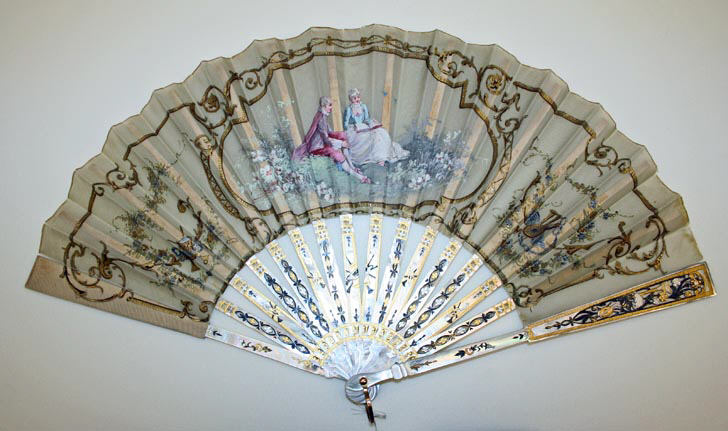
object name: fan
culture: american or european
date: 1867-1900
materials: mother of pearl, silk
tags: men,women